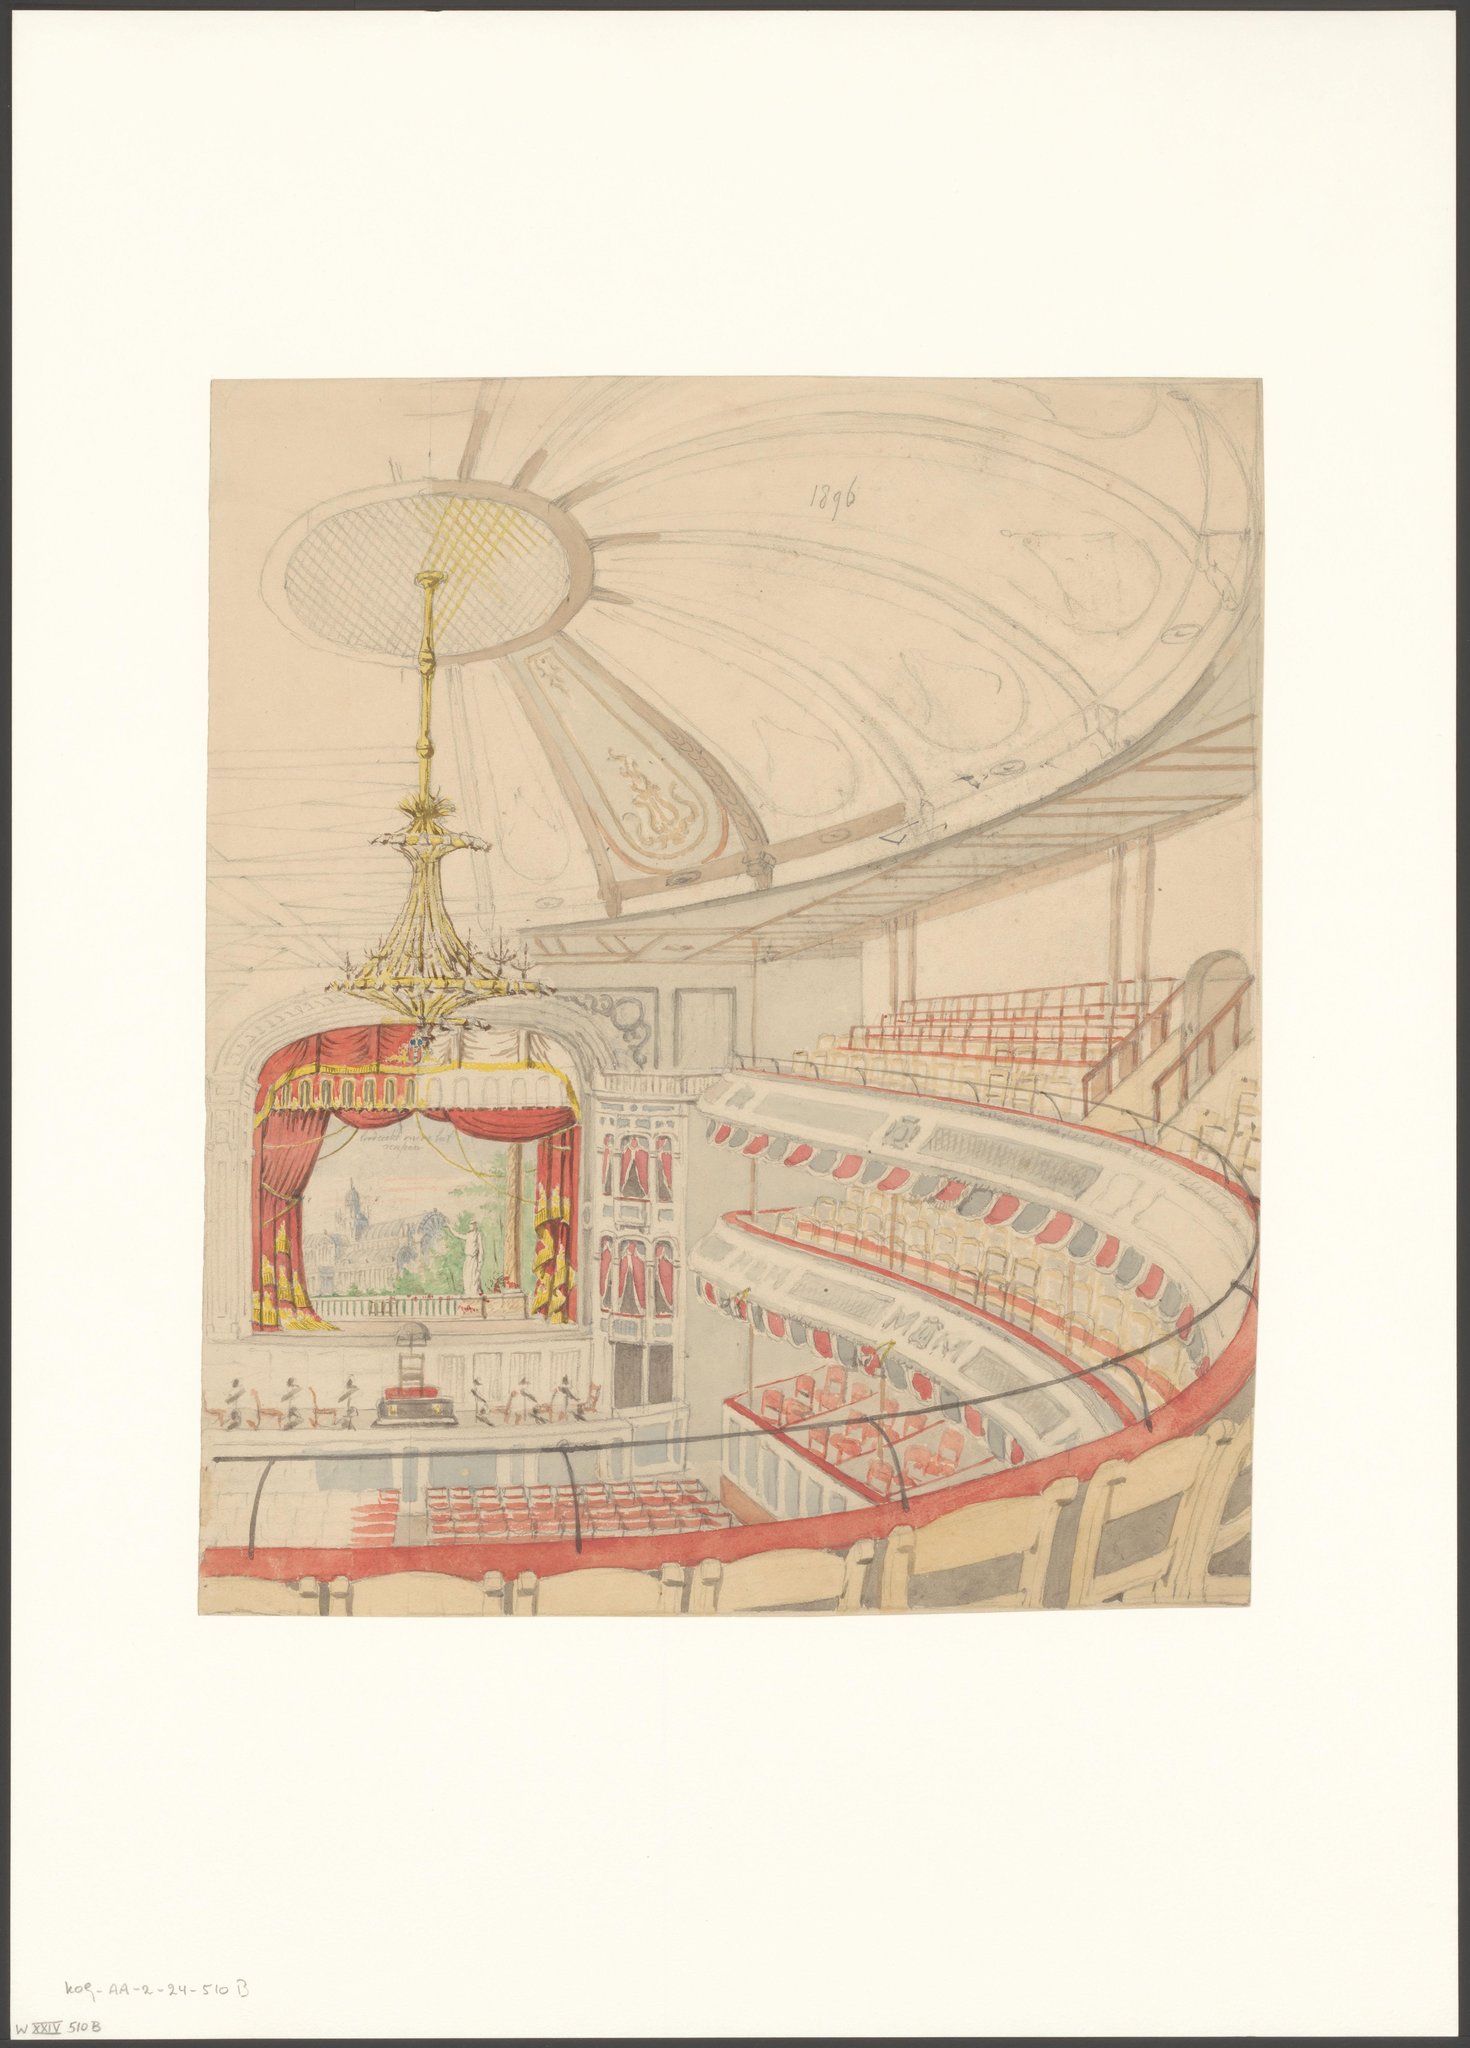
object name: drawing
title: Interieur van de schouwburgzaal van het Paleis voor Volksvlijt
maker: johan martinus anthon rieke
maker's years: 1851-1899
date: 1896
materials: paper, pencil, watercolor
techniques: brush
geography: amsterdam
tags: theatre, theatrical performance, the stage and its equipment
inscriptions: date: ‘1896’, inscription: ‘loodrecht onder het / wapen’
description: Tekening binnen de Atlas Van Eck ingedeeld op wijknummer 24.